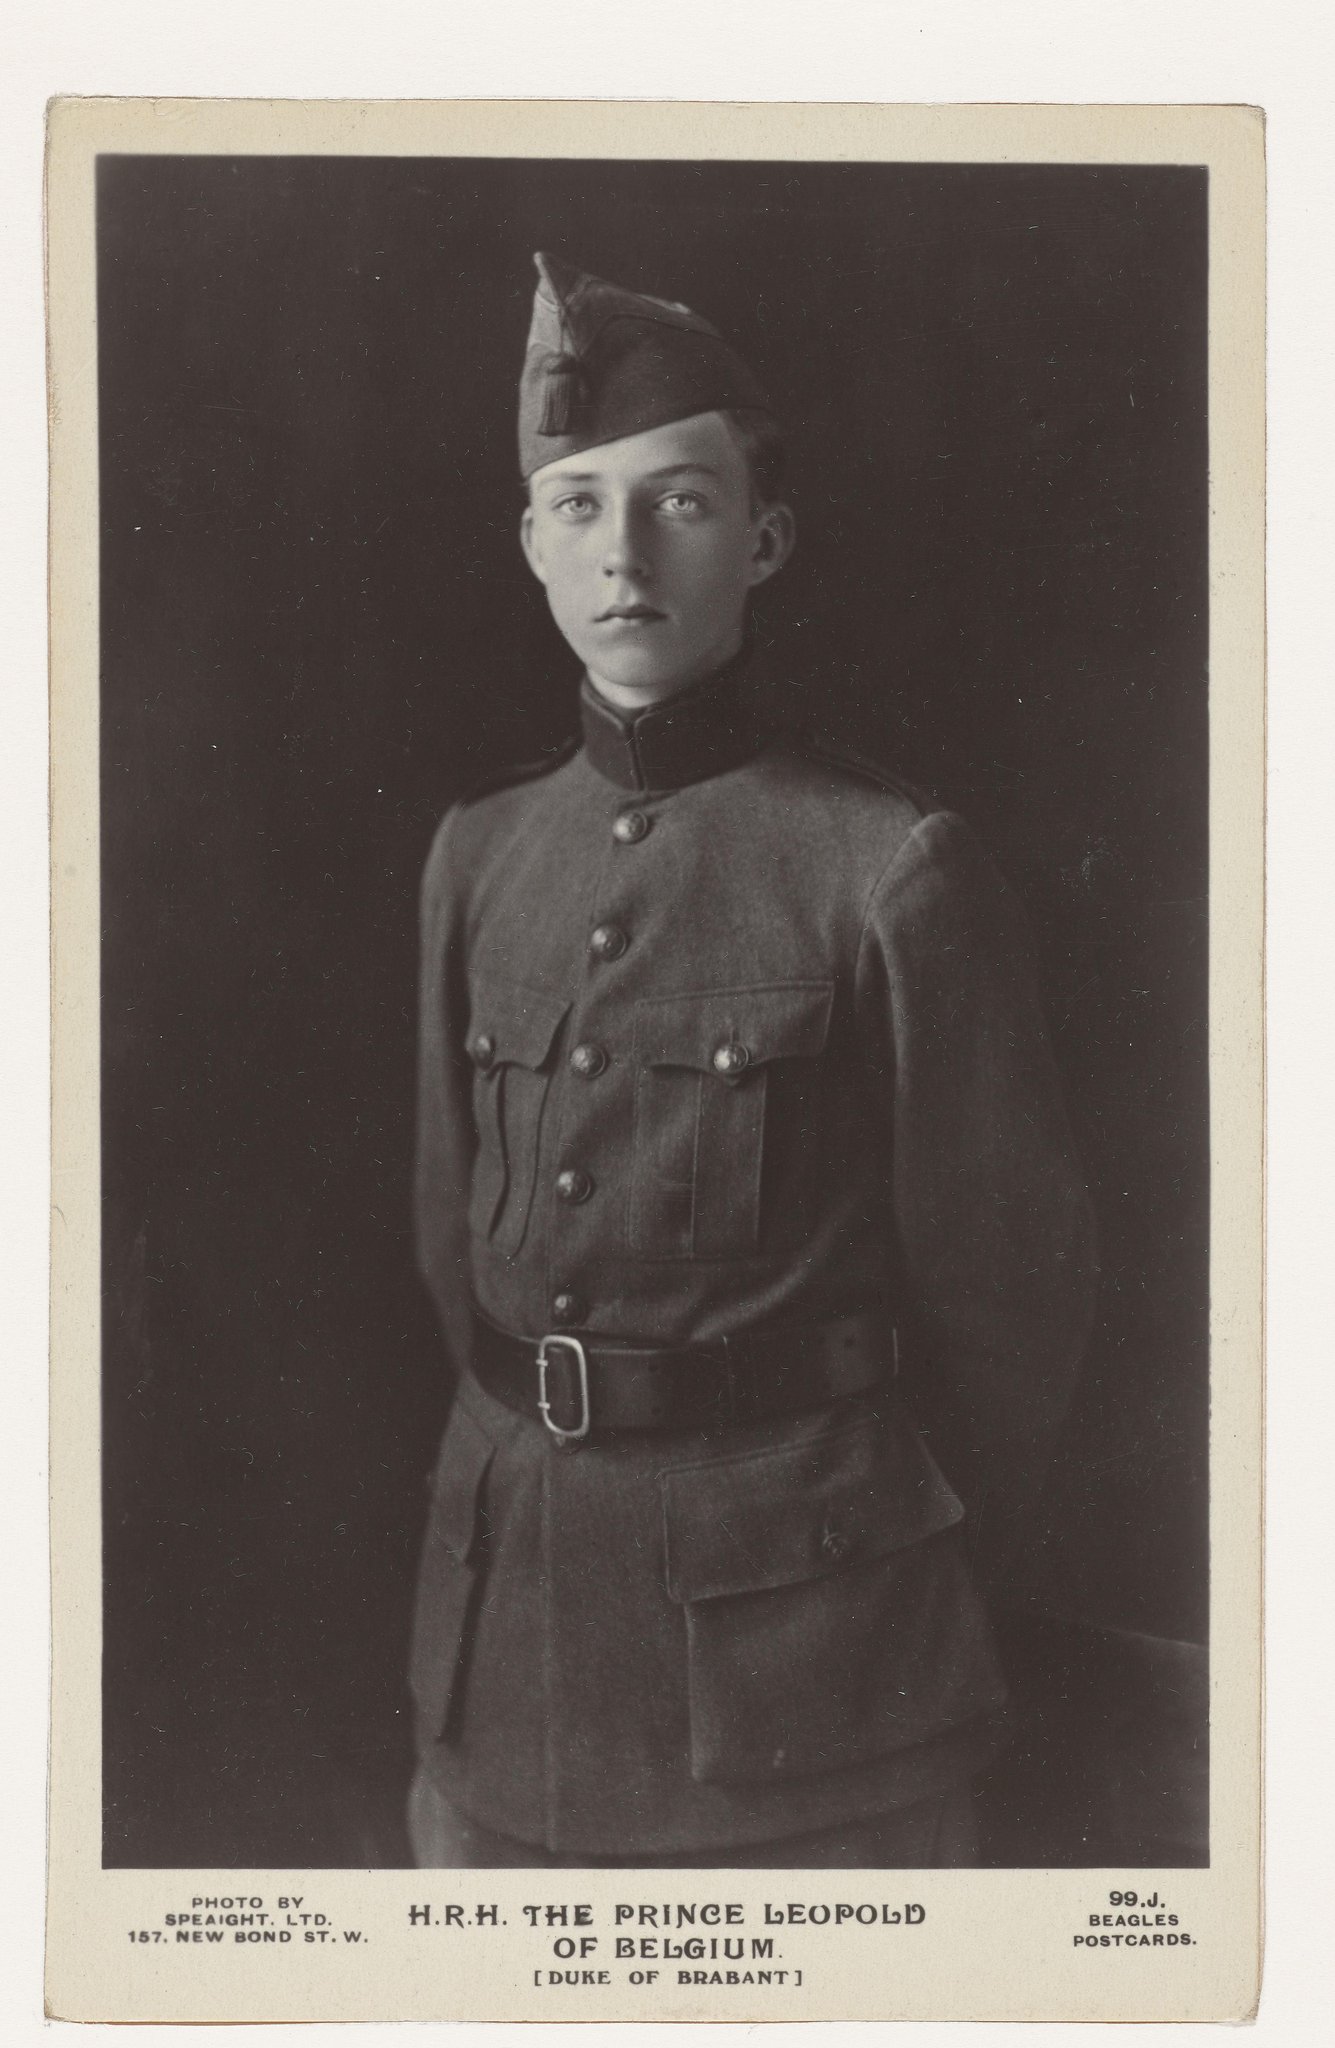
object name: ansichtkaart, prentbriefkaart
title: H.R.H. the prince Leopold of Belgium (Duke of Brabant)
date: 1914-1918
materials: paper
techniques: gelatin silver print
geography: london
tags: brussels, prince, historical persons, europe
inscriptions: inscription: ‘J. BEAGLES & Co Ltd. E.C. Printers & Publishers./ GUARANTEED REAL PHOTOGRAPH.’, number: ‘99.J.’, address: ‘187 NEW BOND ST W.’